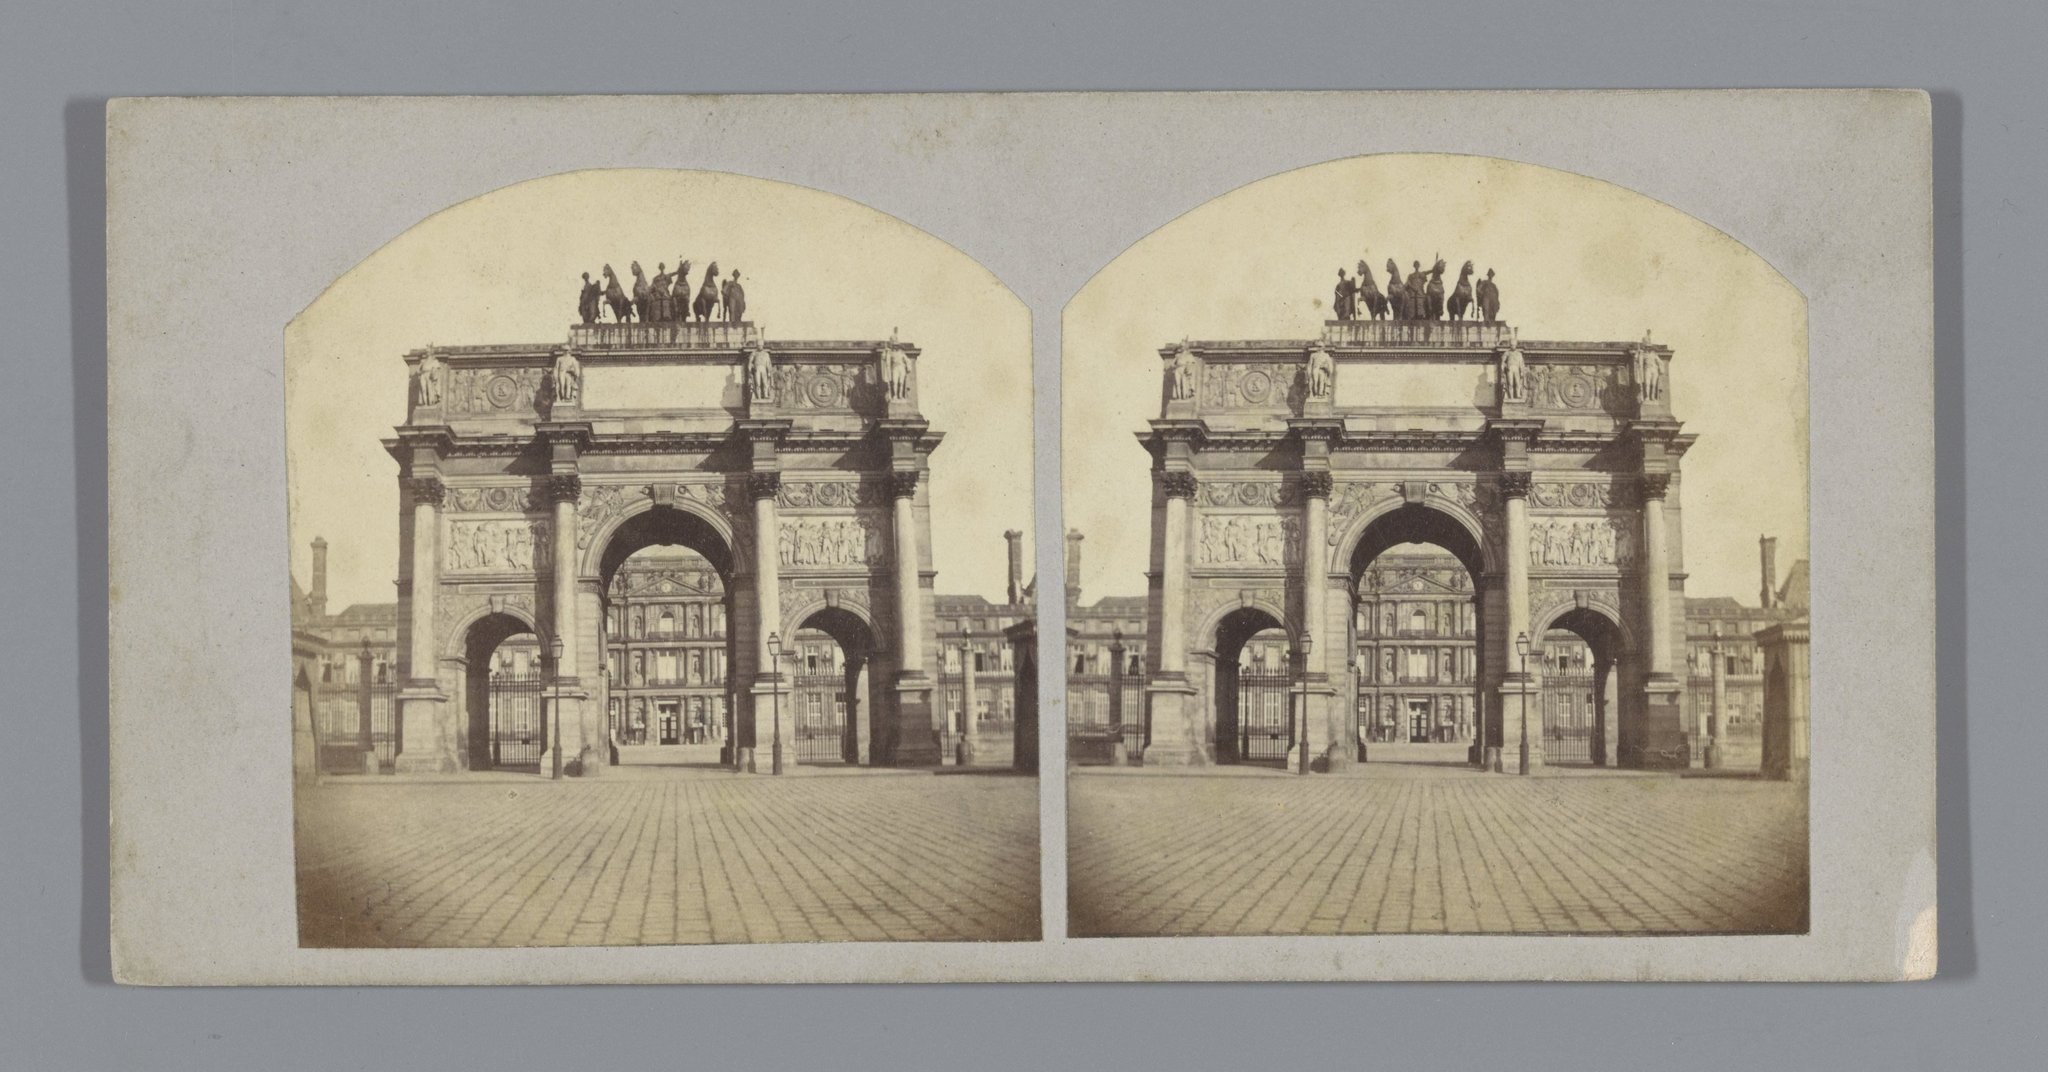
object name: stereograph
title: Arc de Triomphe du Carrousel, Parijs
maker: Anonymous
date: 1860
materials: cardboard, photographic support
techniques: albumen print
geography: paris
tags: monument, statue